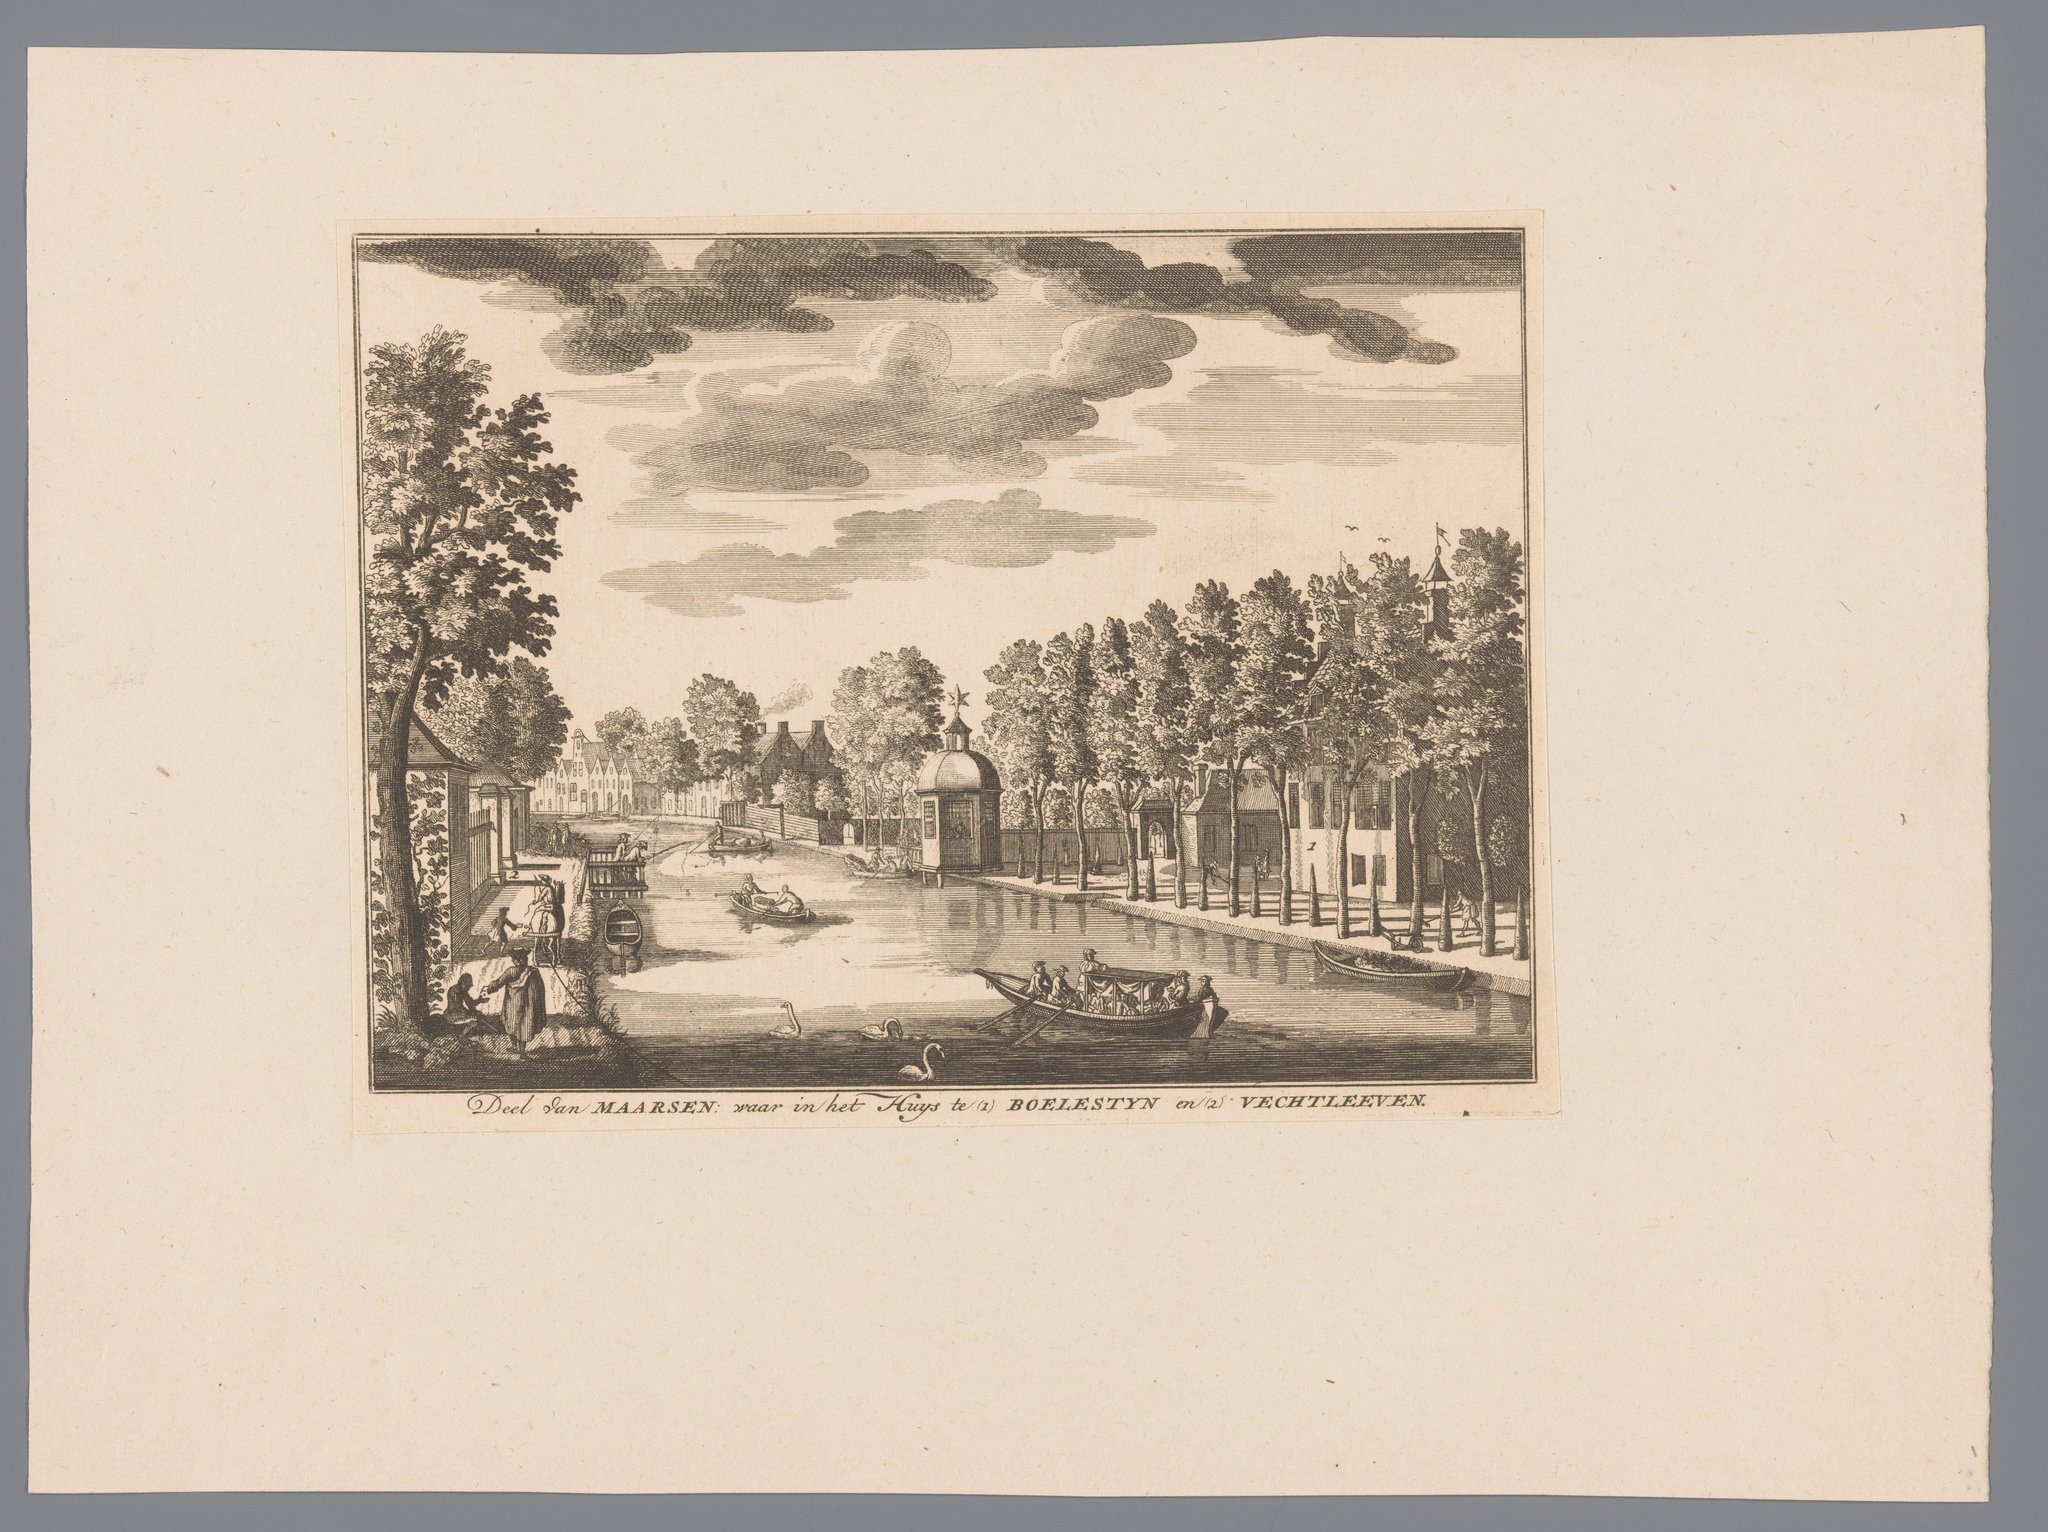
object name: print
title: Gezicht op Maarssen met huis Bolenstein en Vechtleven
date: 1718-1757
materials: paper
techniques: etching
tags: river, rural housing, e.g. country-house, villa, cottage, maarssen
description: Naar prent in: Stopendaal, Daniel. De zegepraalende Vecht, vertoonende verscheidenen gesichten van lustplaatsen, heeren huysen en dorpen, beginnende van Uitrecht en met Muyden besluytende. Amsterdam: Weduwe Nicolaas Visscher, 1719.